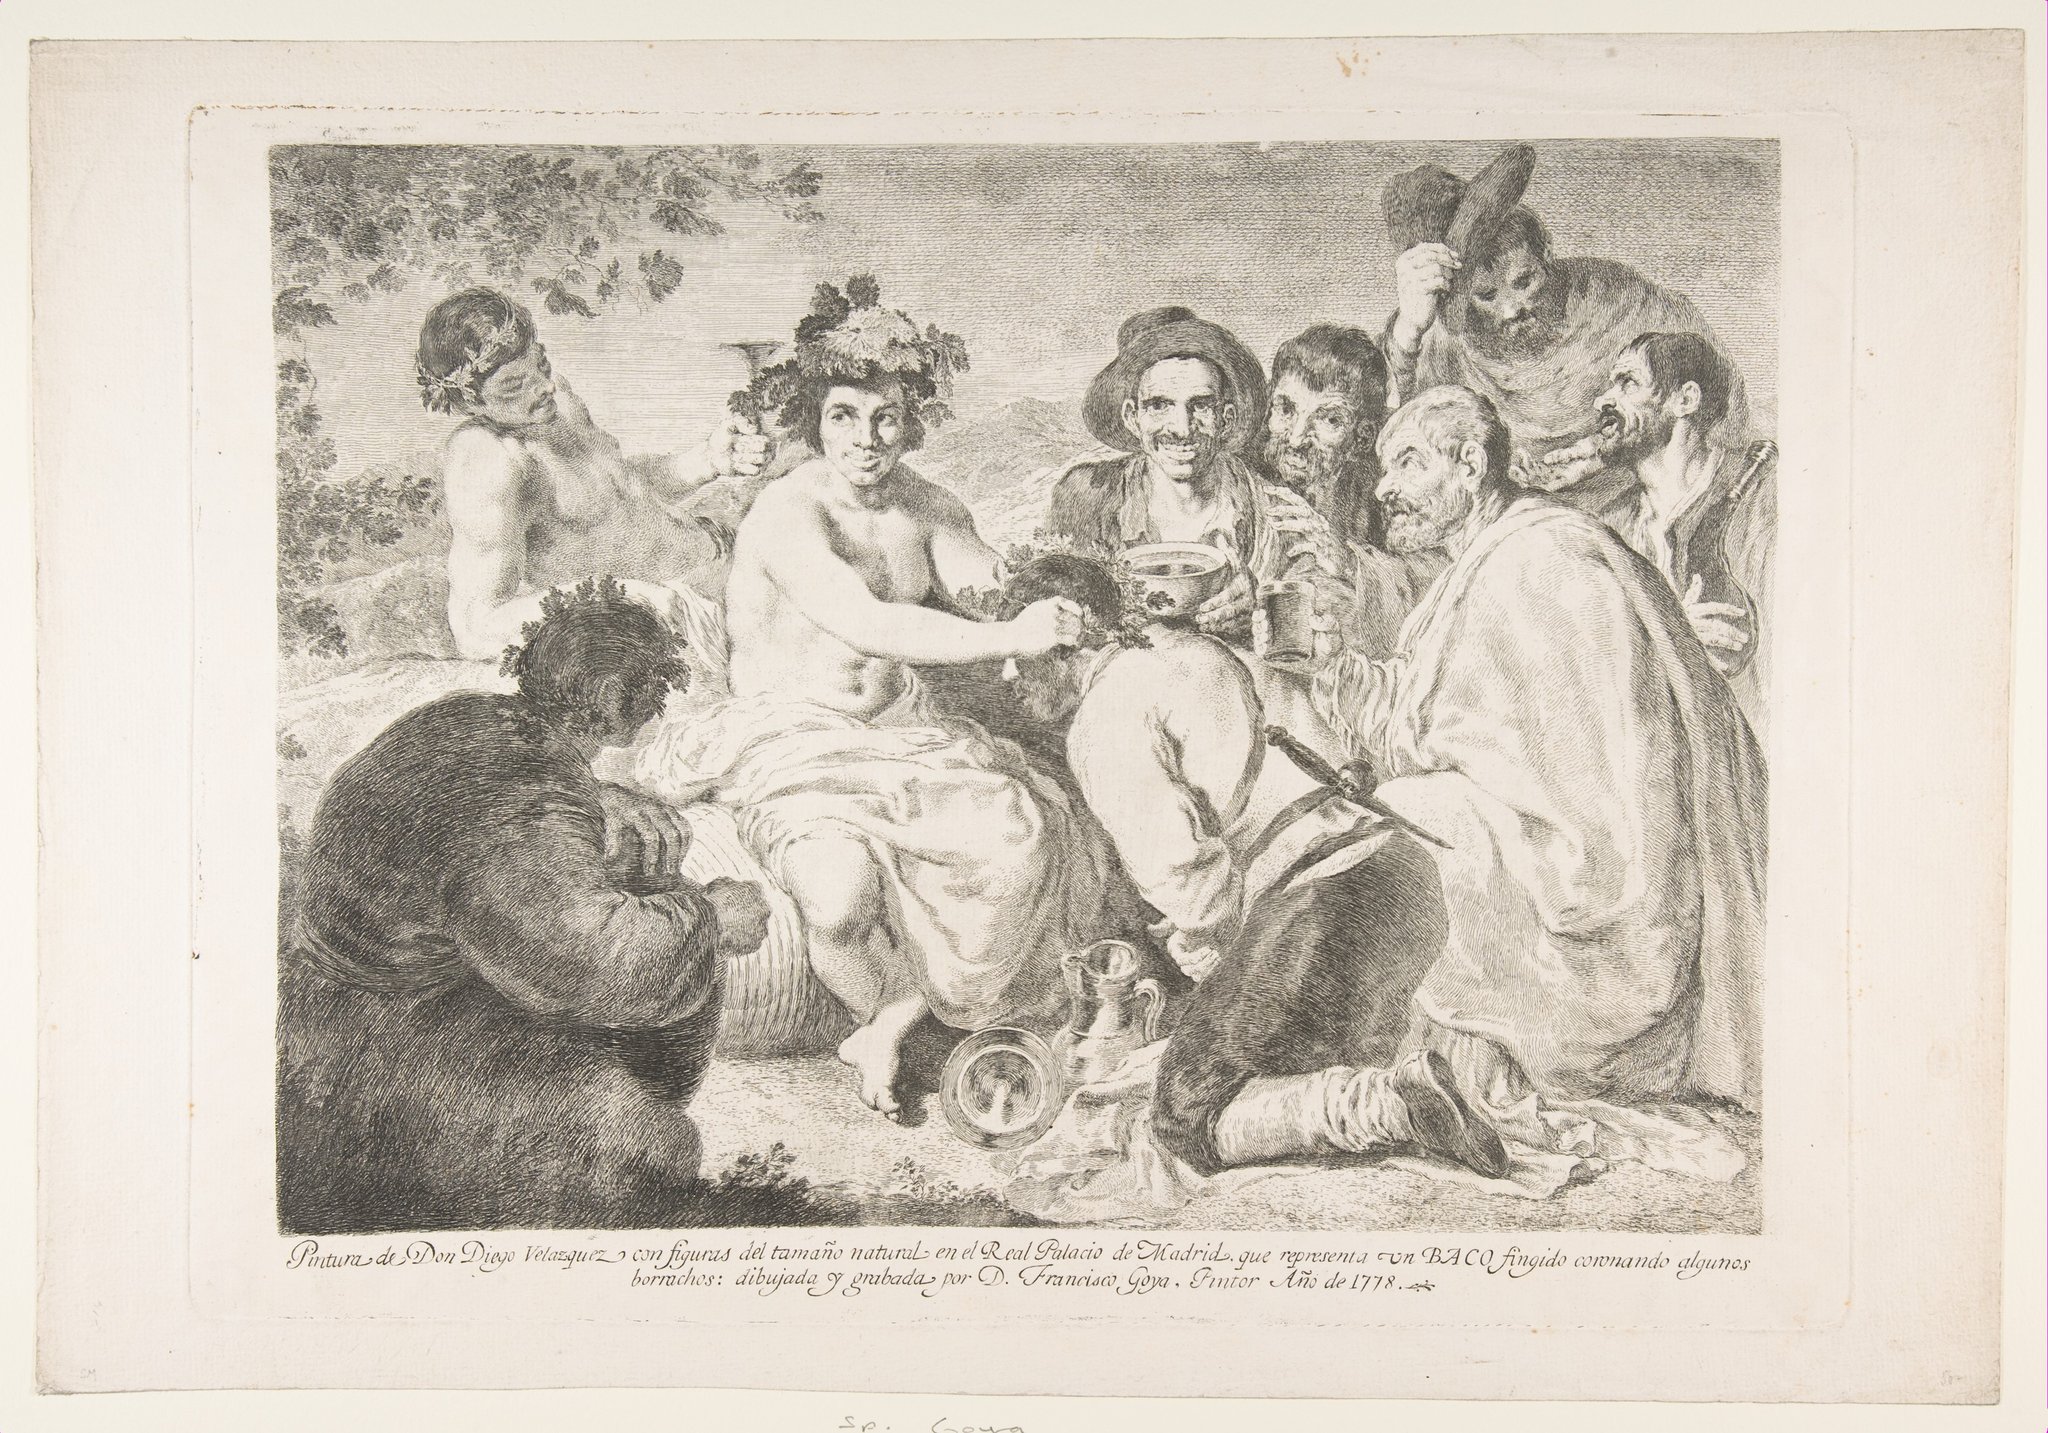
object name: print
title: A False Bacchus Crowning Drunkards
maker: goya (francisco de goya y lucientes)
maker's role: artist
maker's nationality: spanish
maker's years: 1746-1828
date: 1778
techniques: etching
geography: spain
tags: drunkenness,men,drinking